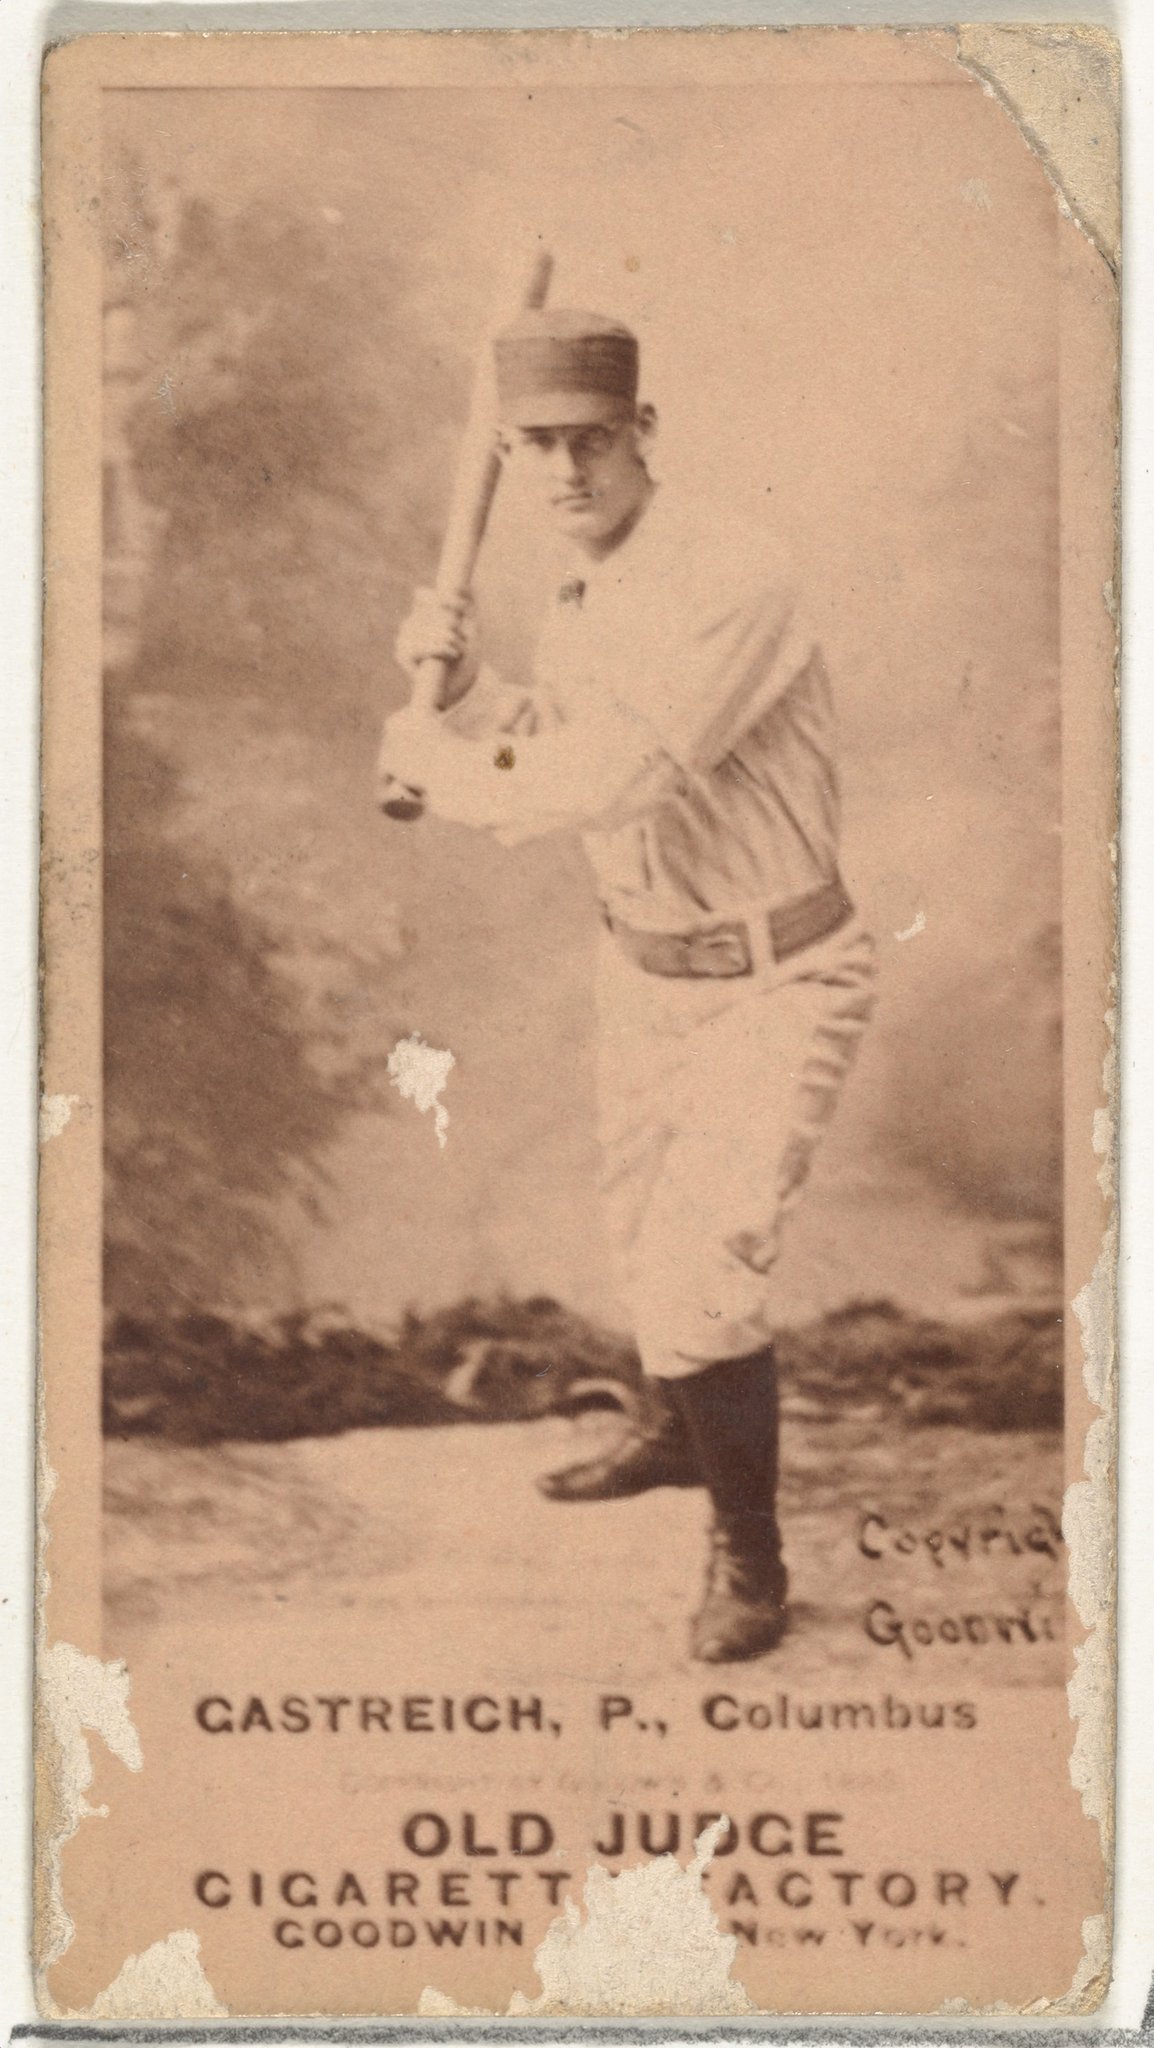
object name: baseball card, photograph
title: Henry Carl "Hank" Gastright, Pitcher, Cleveland, from the Old Judge series (N172) for Old Judge Cigarettes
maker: goodwin & company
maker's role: publisher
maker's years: 1850-1950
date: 1889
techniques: albumen silver print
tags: men,portraits,baseball,athletes